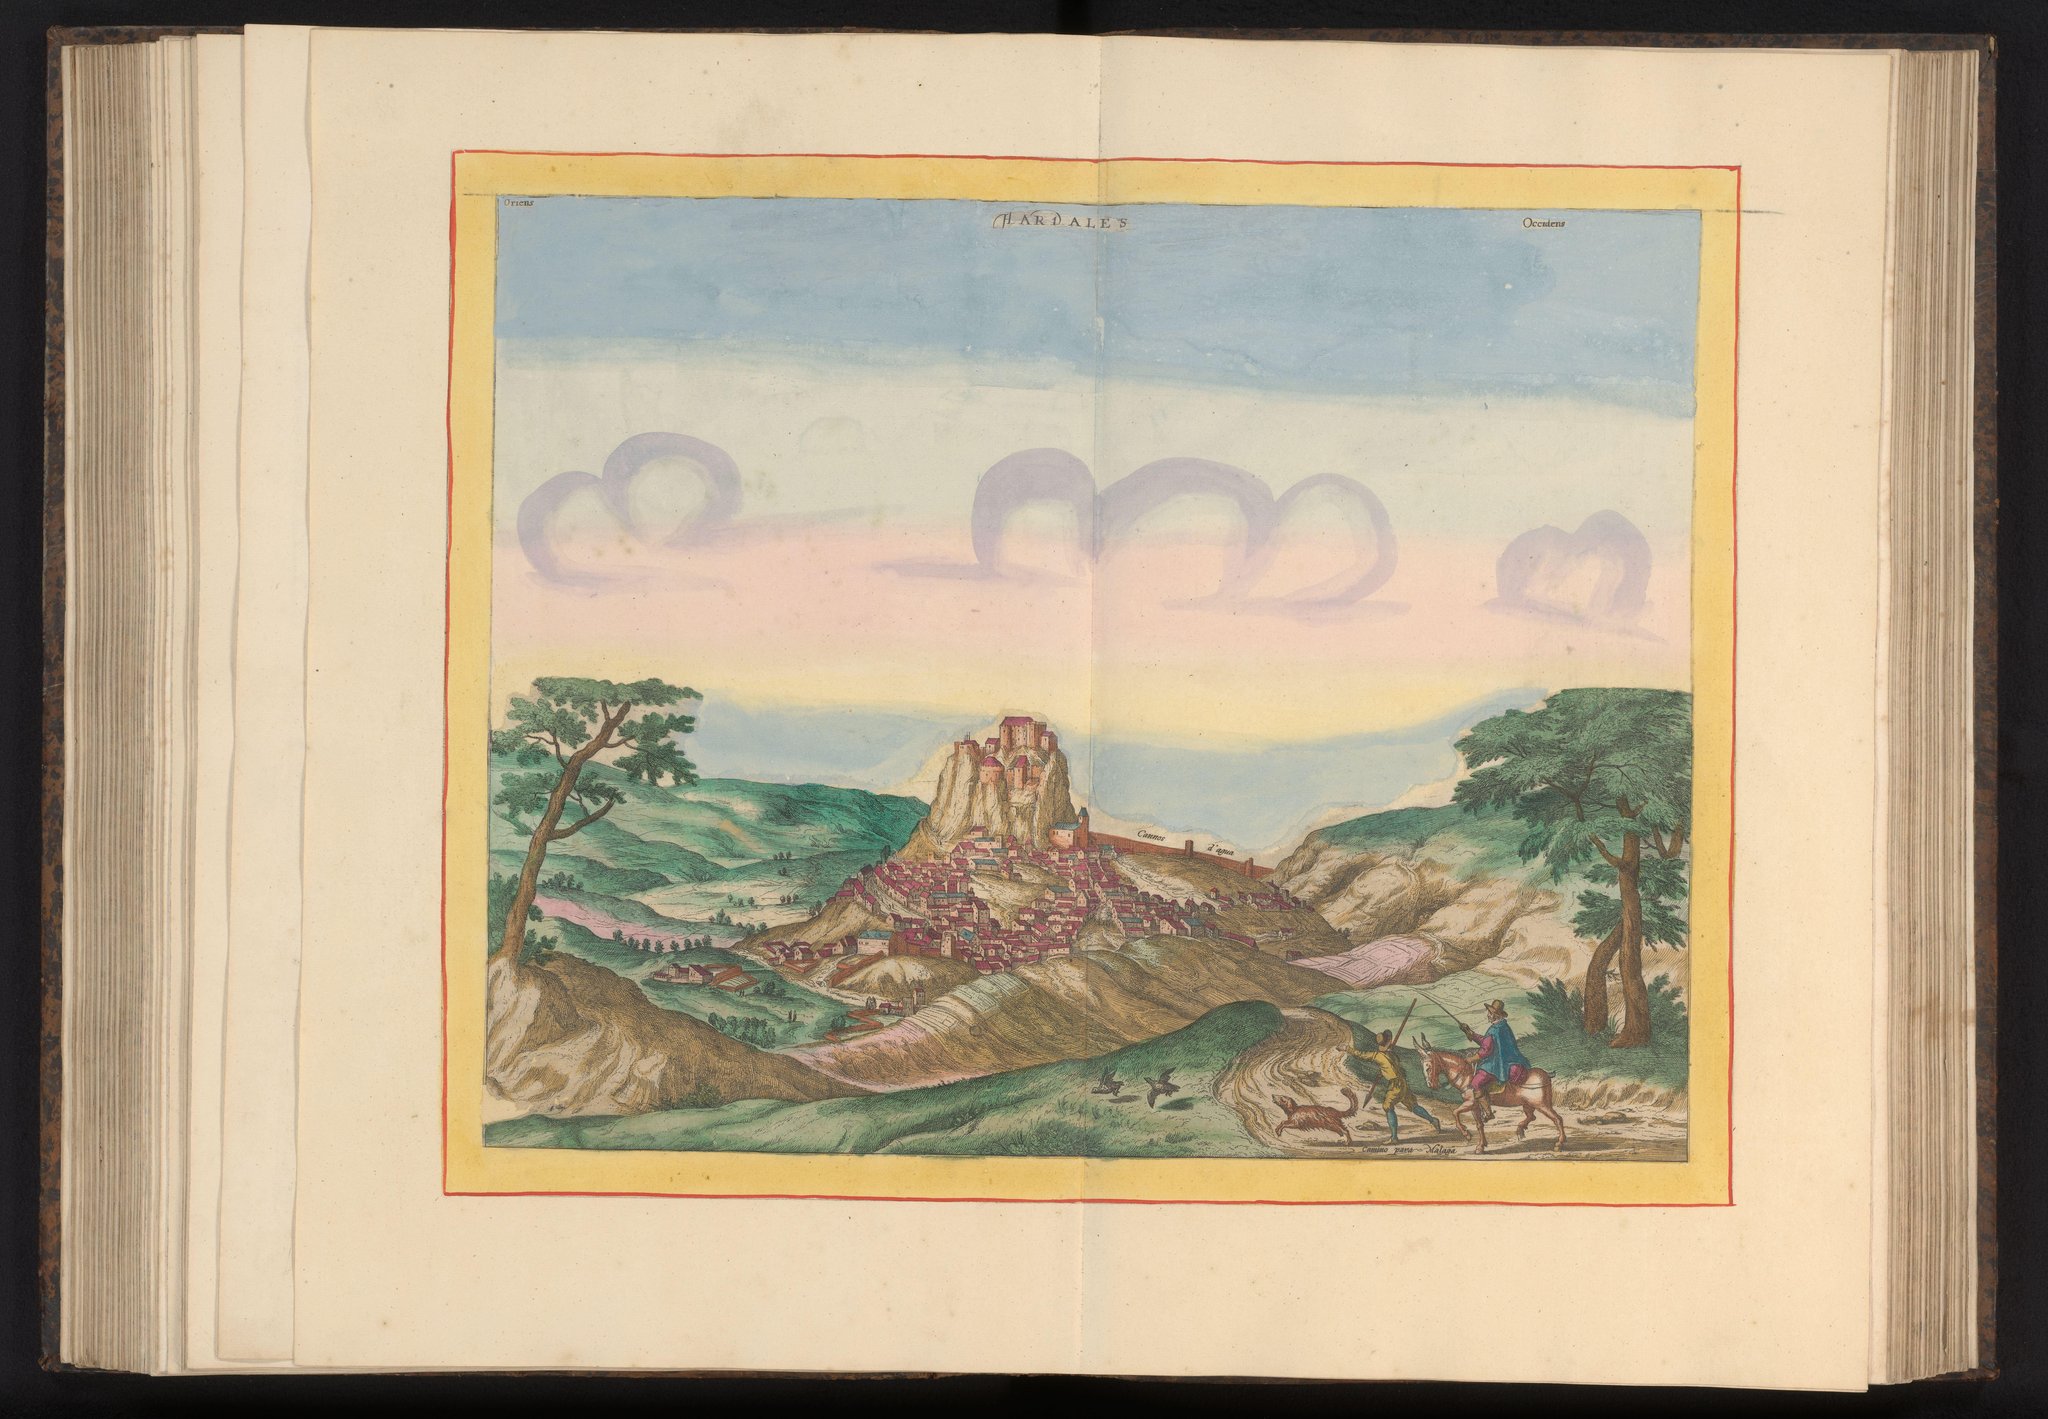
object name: book illustration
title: Hardales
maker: anna beeck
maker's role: publisher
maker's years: 1657-1717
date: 1596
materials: paper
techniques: engraving, etching, hand coloring, letterpress printing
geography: the hague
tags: city-view in general; 'veduta'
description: Prent origineel vervaardigd als boekillustratie voor: Georg Braun en Frans Hogenberg. Civitates Orbis Terrarum, 6 delen. Keulen: 1572-1617. De prent werd voor het eerst gepubliceerd in deel 5: Urbium praecipuarum mundi theatrum quintum, 1596. De prent is langs de bovenrand van de heuvels afgescheurd. Het bovenste gedeelte met de lucht is hoger opgeplakt, zodat de lucht hoger is geworden en het formaat van de voorstelling past bij de andere groot formaatvoorstellingen in het album.